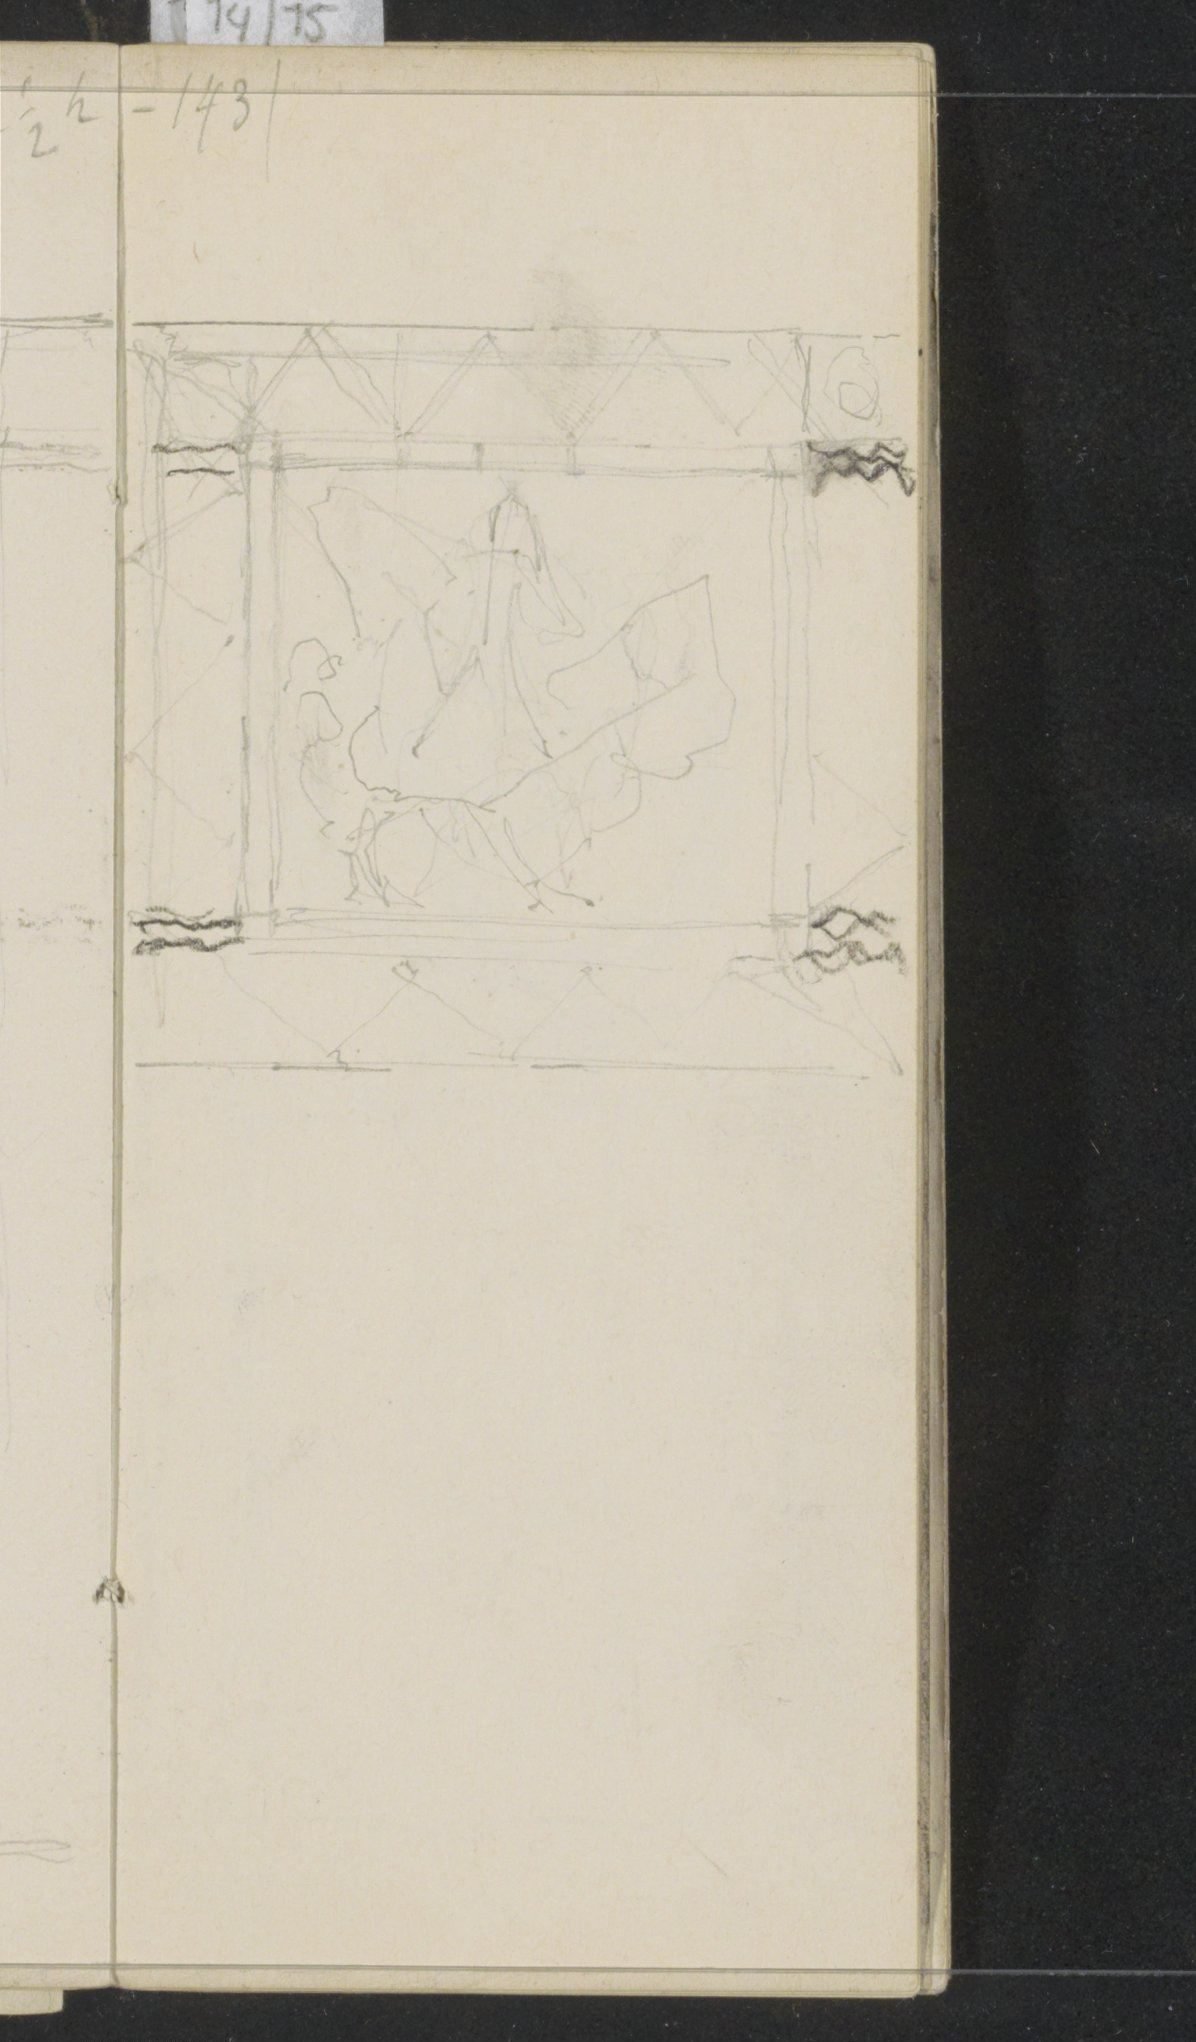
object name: sketchbook leaf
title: Voorstelling in een decoratieve vierkante omlijsting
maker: gerrit willem dijsselhof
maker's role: designer, draughtsman, print maker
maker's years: 1866-1924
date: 1876-1924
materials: chalk, paper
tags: frame of painting, etc.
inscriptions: annotation: ‘[...]’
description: Mogelijk een ontwerp voor een (glas-in-lood)venster. Blad 10 recto uit een schetsboek met 24 bladen.